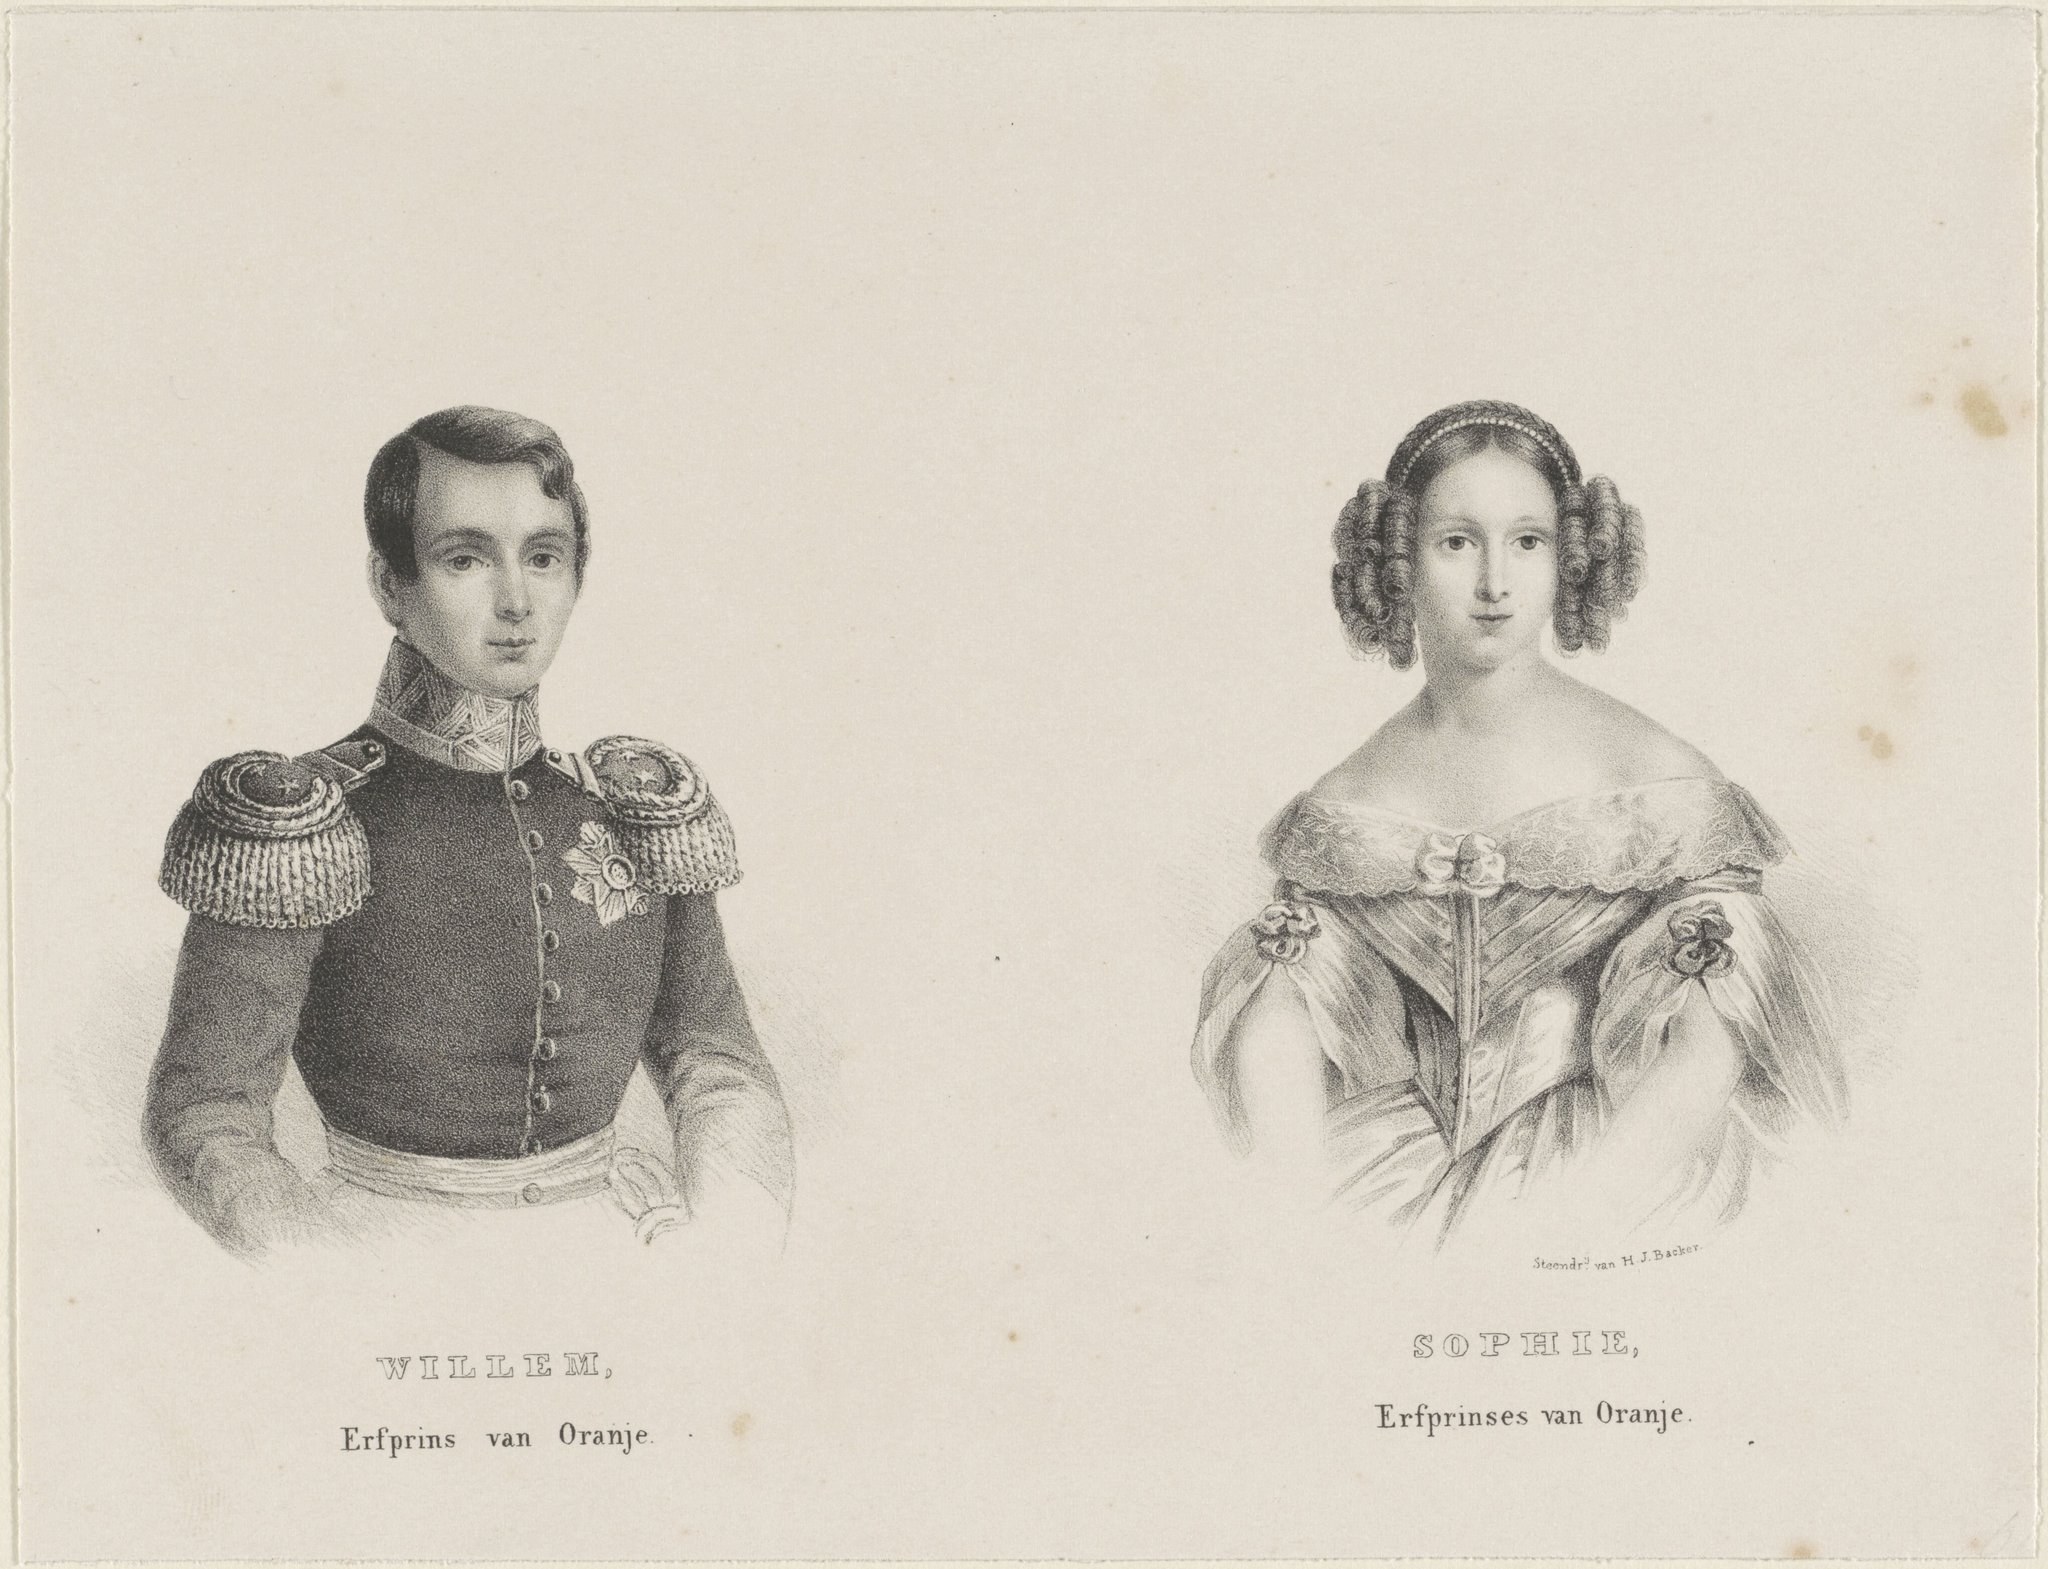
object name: print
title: Portretten van Willem III, koning der Nederlanden, en Sophie van Württemberg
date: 1839-1845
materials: paper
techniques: lithograph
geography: netherlands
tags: brussels, willem iii (koning der nederlanden), the hague, sophia frederika mathilda van württemberg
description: De hier vermelde titel verwijst naar de hoogst verkregen titel van de geportretteerde, niet per se naar de titel die de geportretteerde op deze voorstelling draagt.